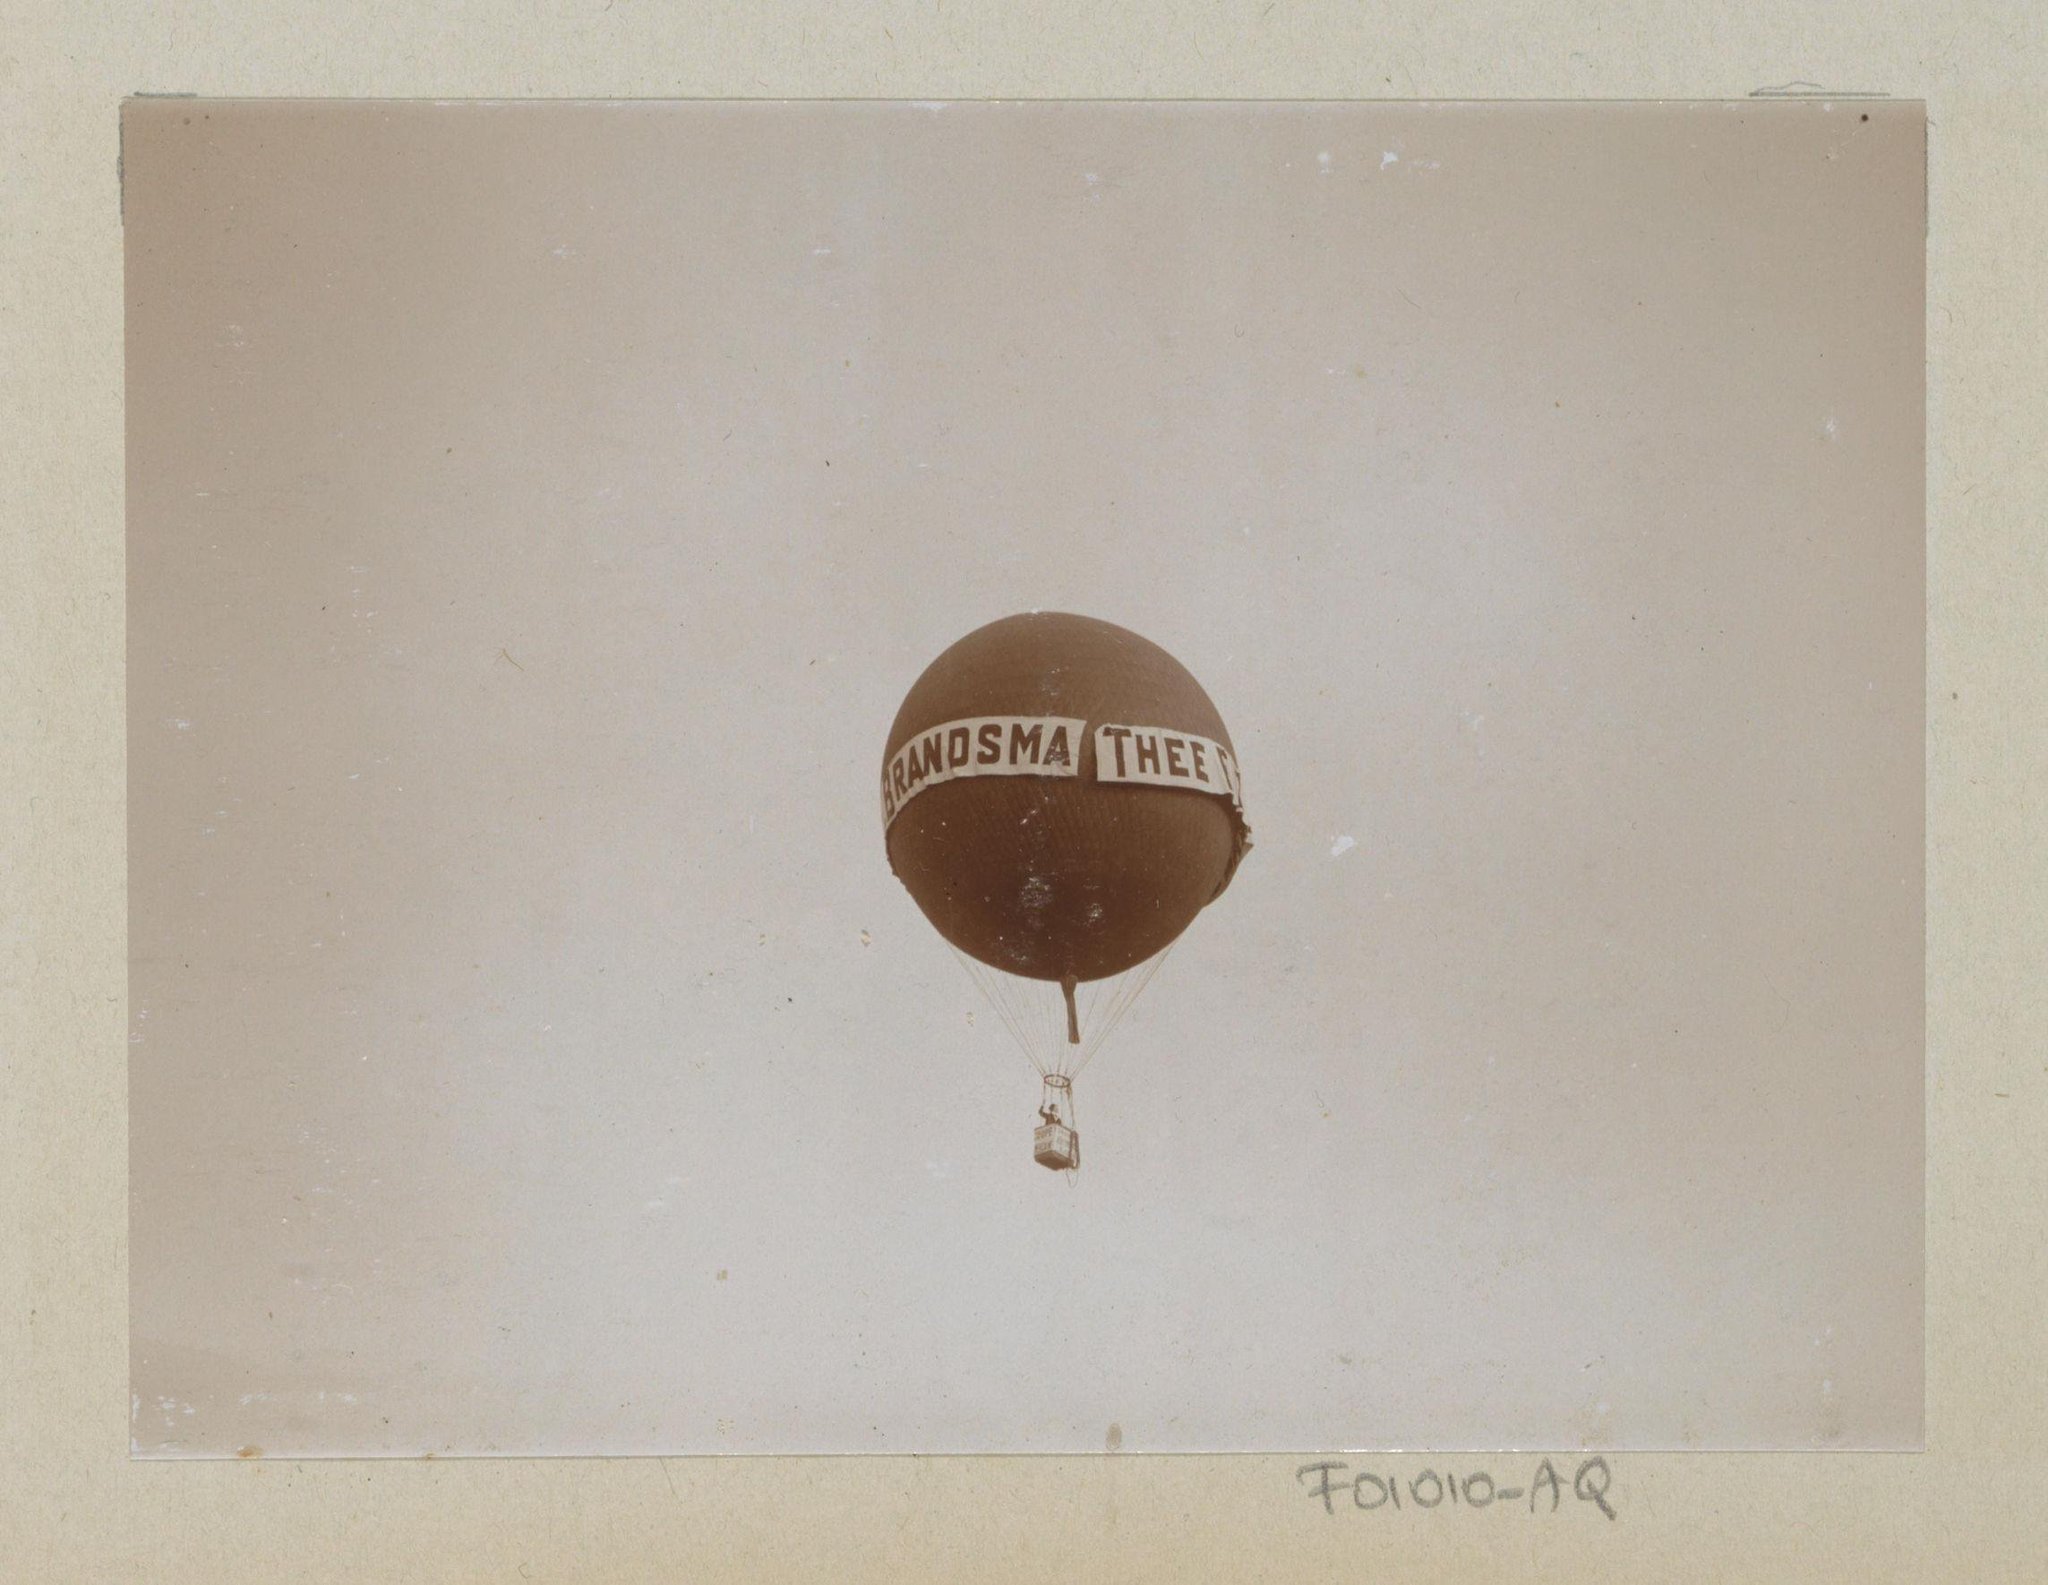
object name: photograph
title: Luchtballon met reclame voor 'Thee E. Brandsma', zwevend in de lucht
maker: Anonymous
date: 1900-1910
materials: photographic support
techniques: collodion silver print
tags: advertising, balloon (aviation)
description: Onderdeel van Familiealbum met onder meer foto's van Wijnhandel Kraaij & Co. Bordeaux-Amsterdam.